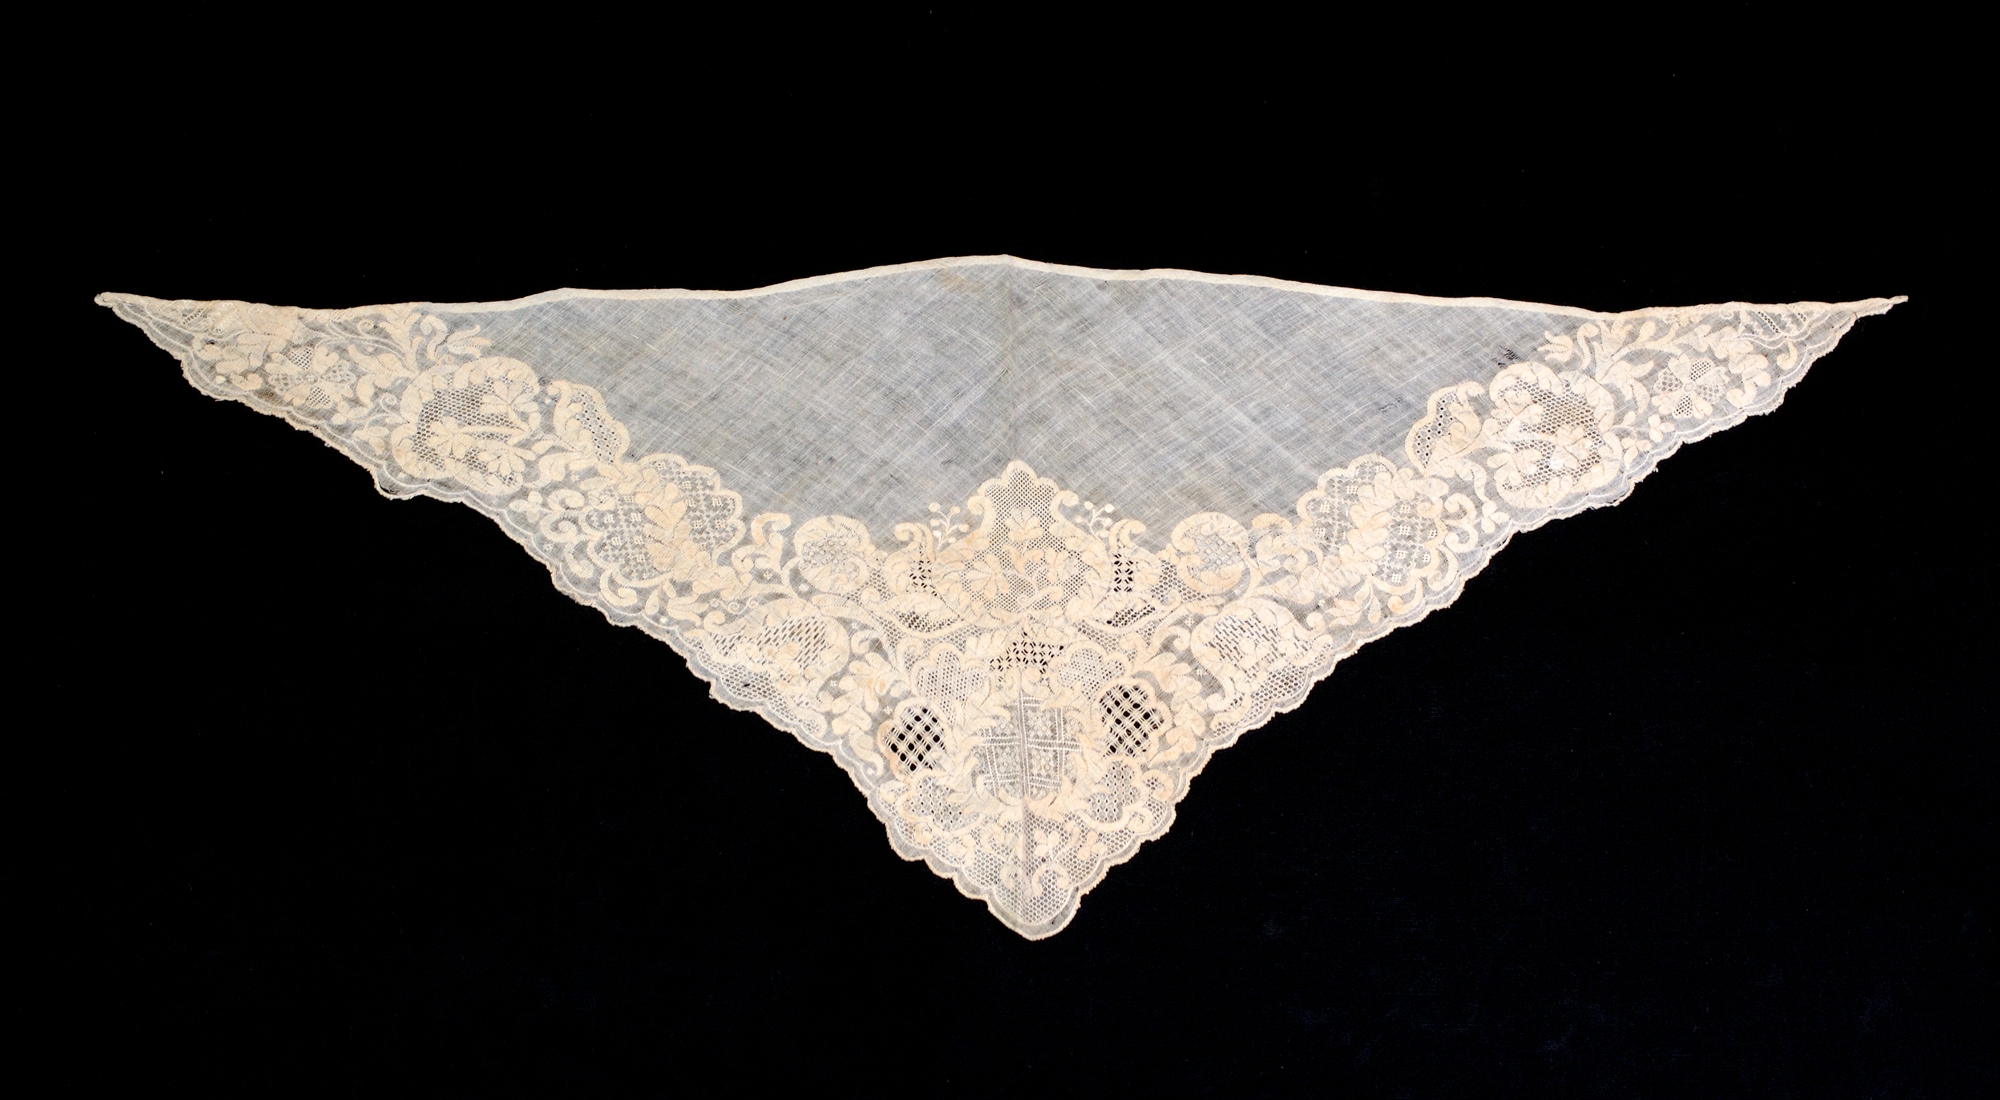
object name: fichu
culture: austrian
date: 1740-1780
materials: linen